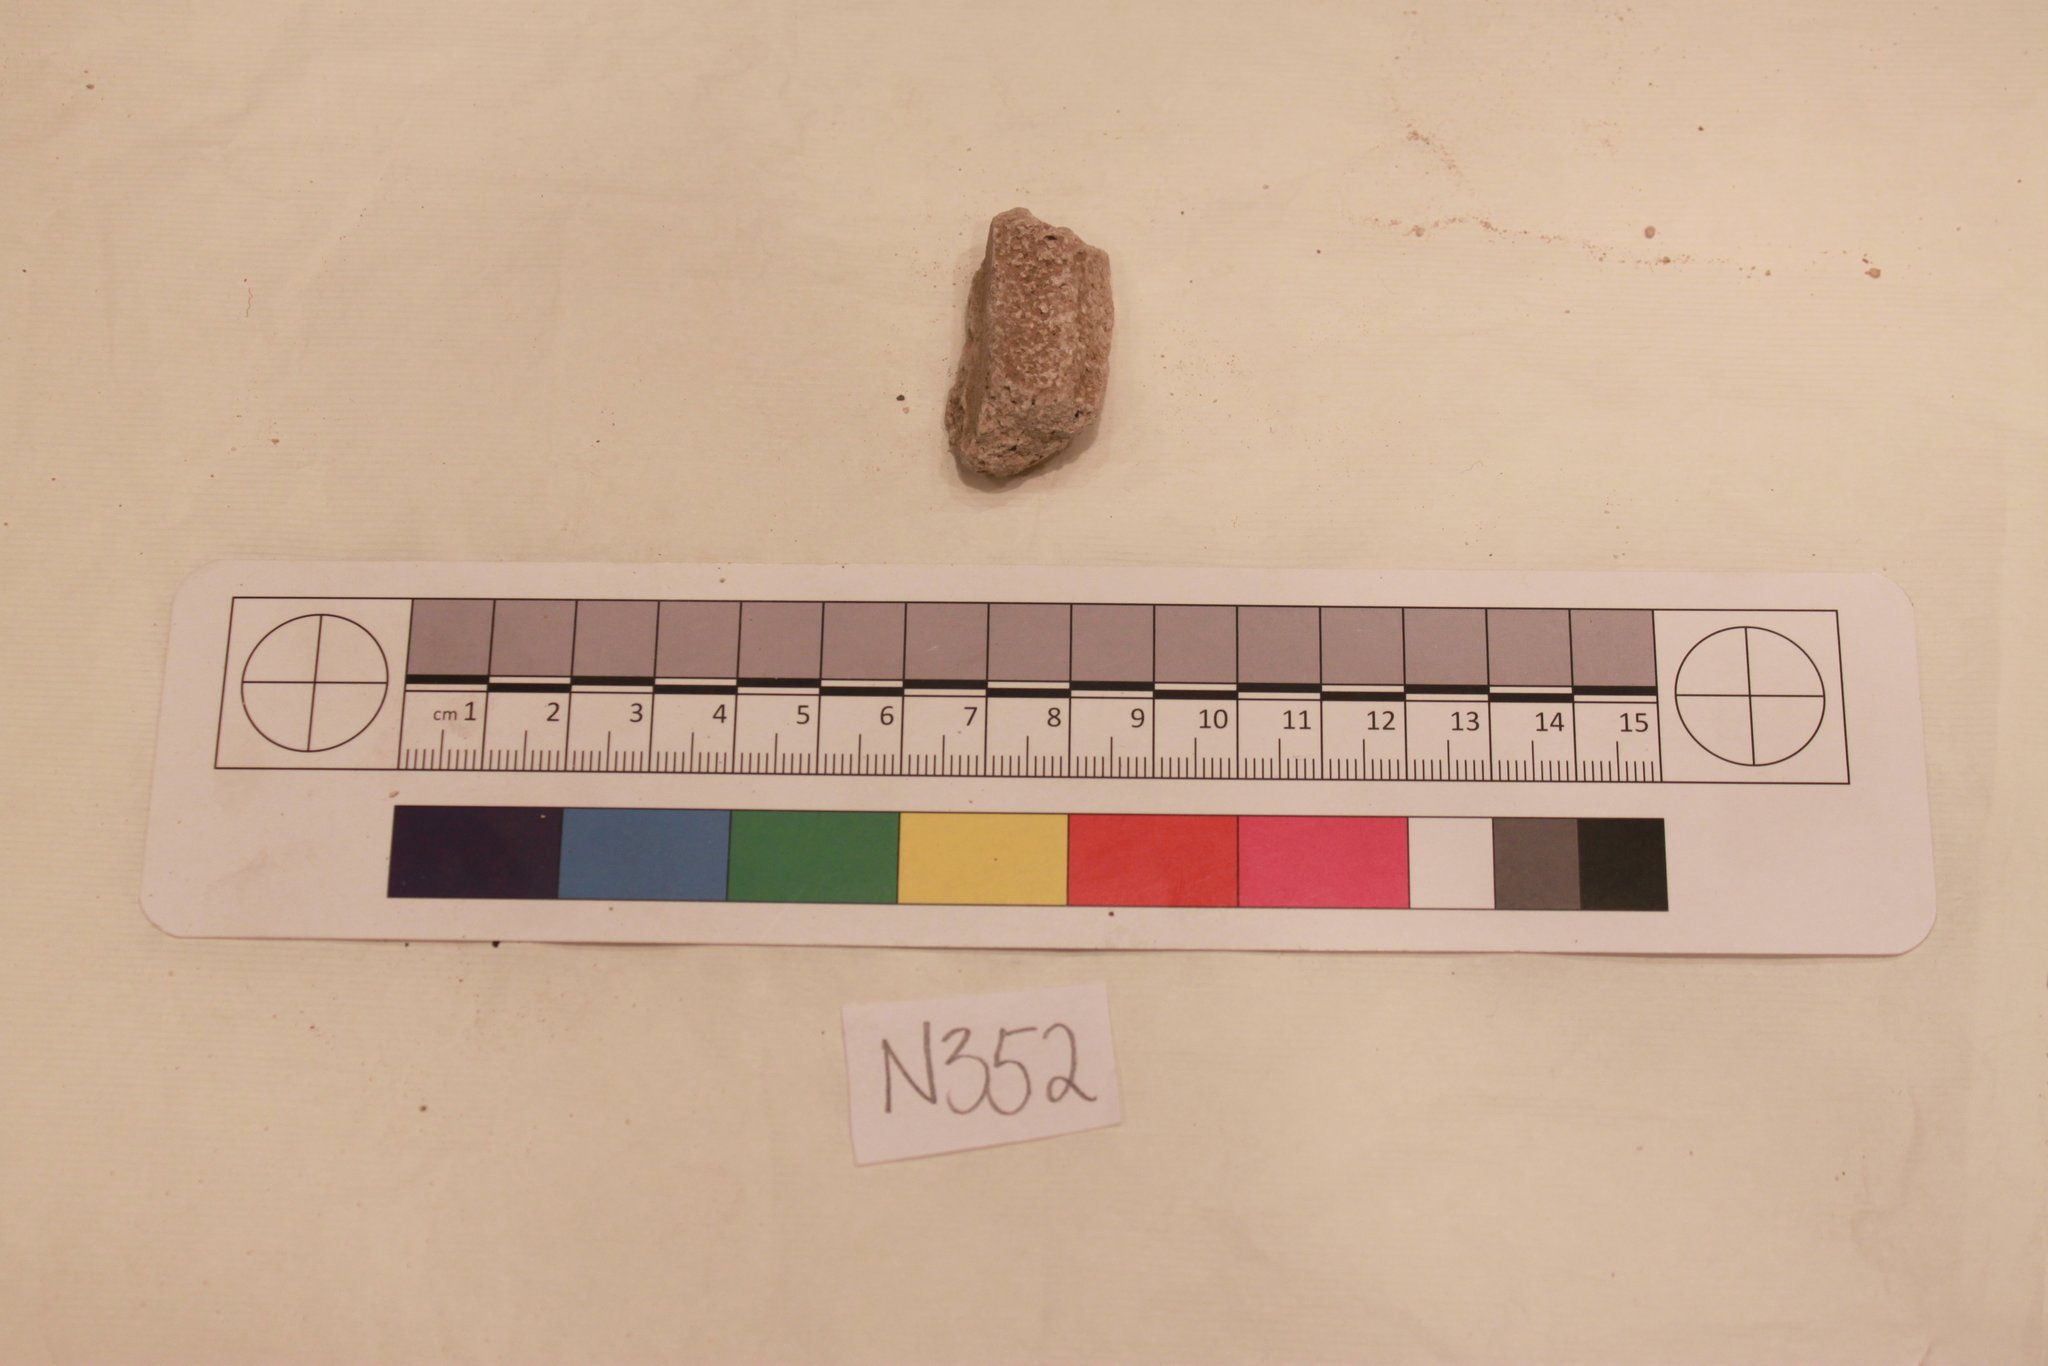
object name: fragment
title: Stucco Fragment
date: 701-1200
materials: plaster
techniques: carving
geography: iran